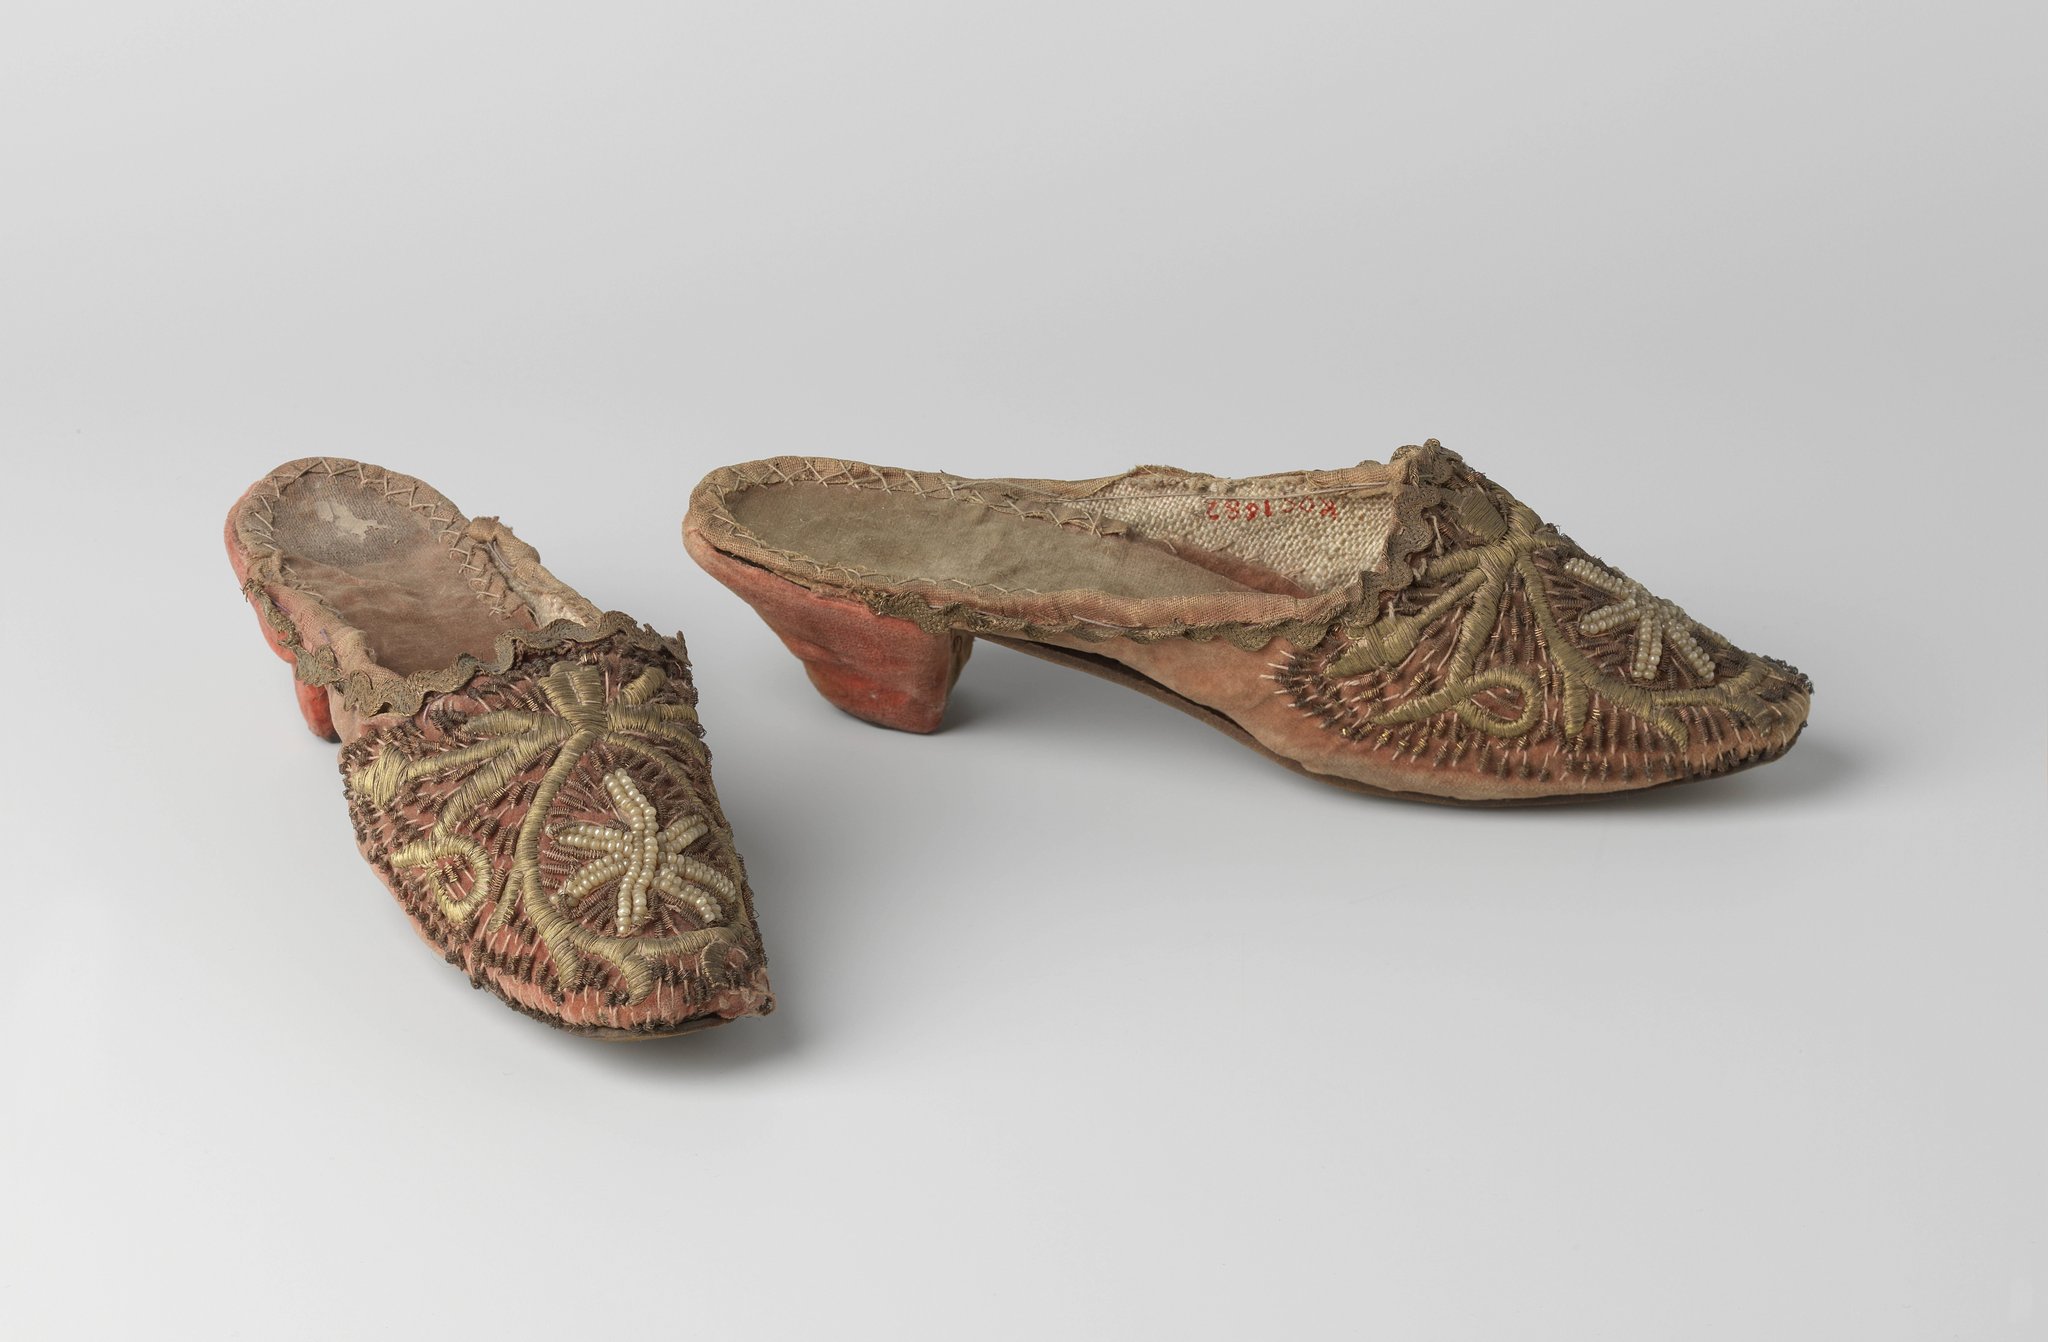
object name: womenswear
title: Damesmuil met hoge hak van roze fluweel, versierd met gouddraad en kralen van parelmoer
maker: Anonymous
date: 1850-1900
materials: glass, gold thread, leather, linen, velvet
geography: netherlands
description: Damesmuil, van roze fluweel, versierd met gouddraad en kralen van parelmoer. Model: afgeplatte ronde neus en hoge hak, naar de voorzijde blokvormig. Met linnen gevoerd.